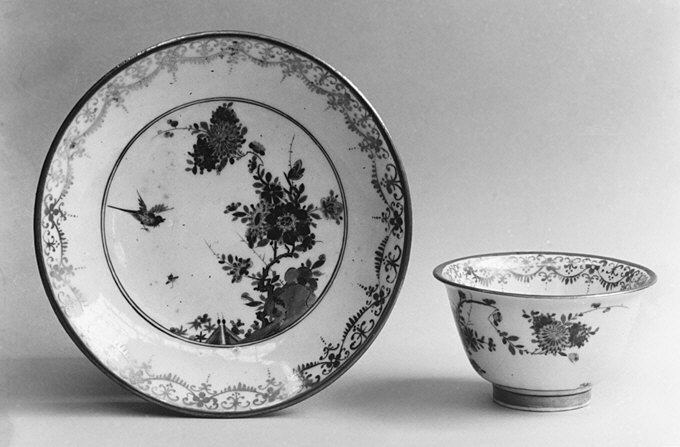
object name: cup and saucer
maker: meissen manufactory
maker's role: manufactory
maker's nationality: german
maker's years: 1710-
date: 1730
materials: hard paste porcelain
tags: birds,flowers